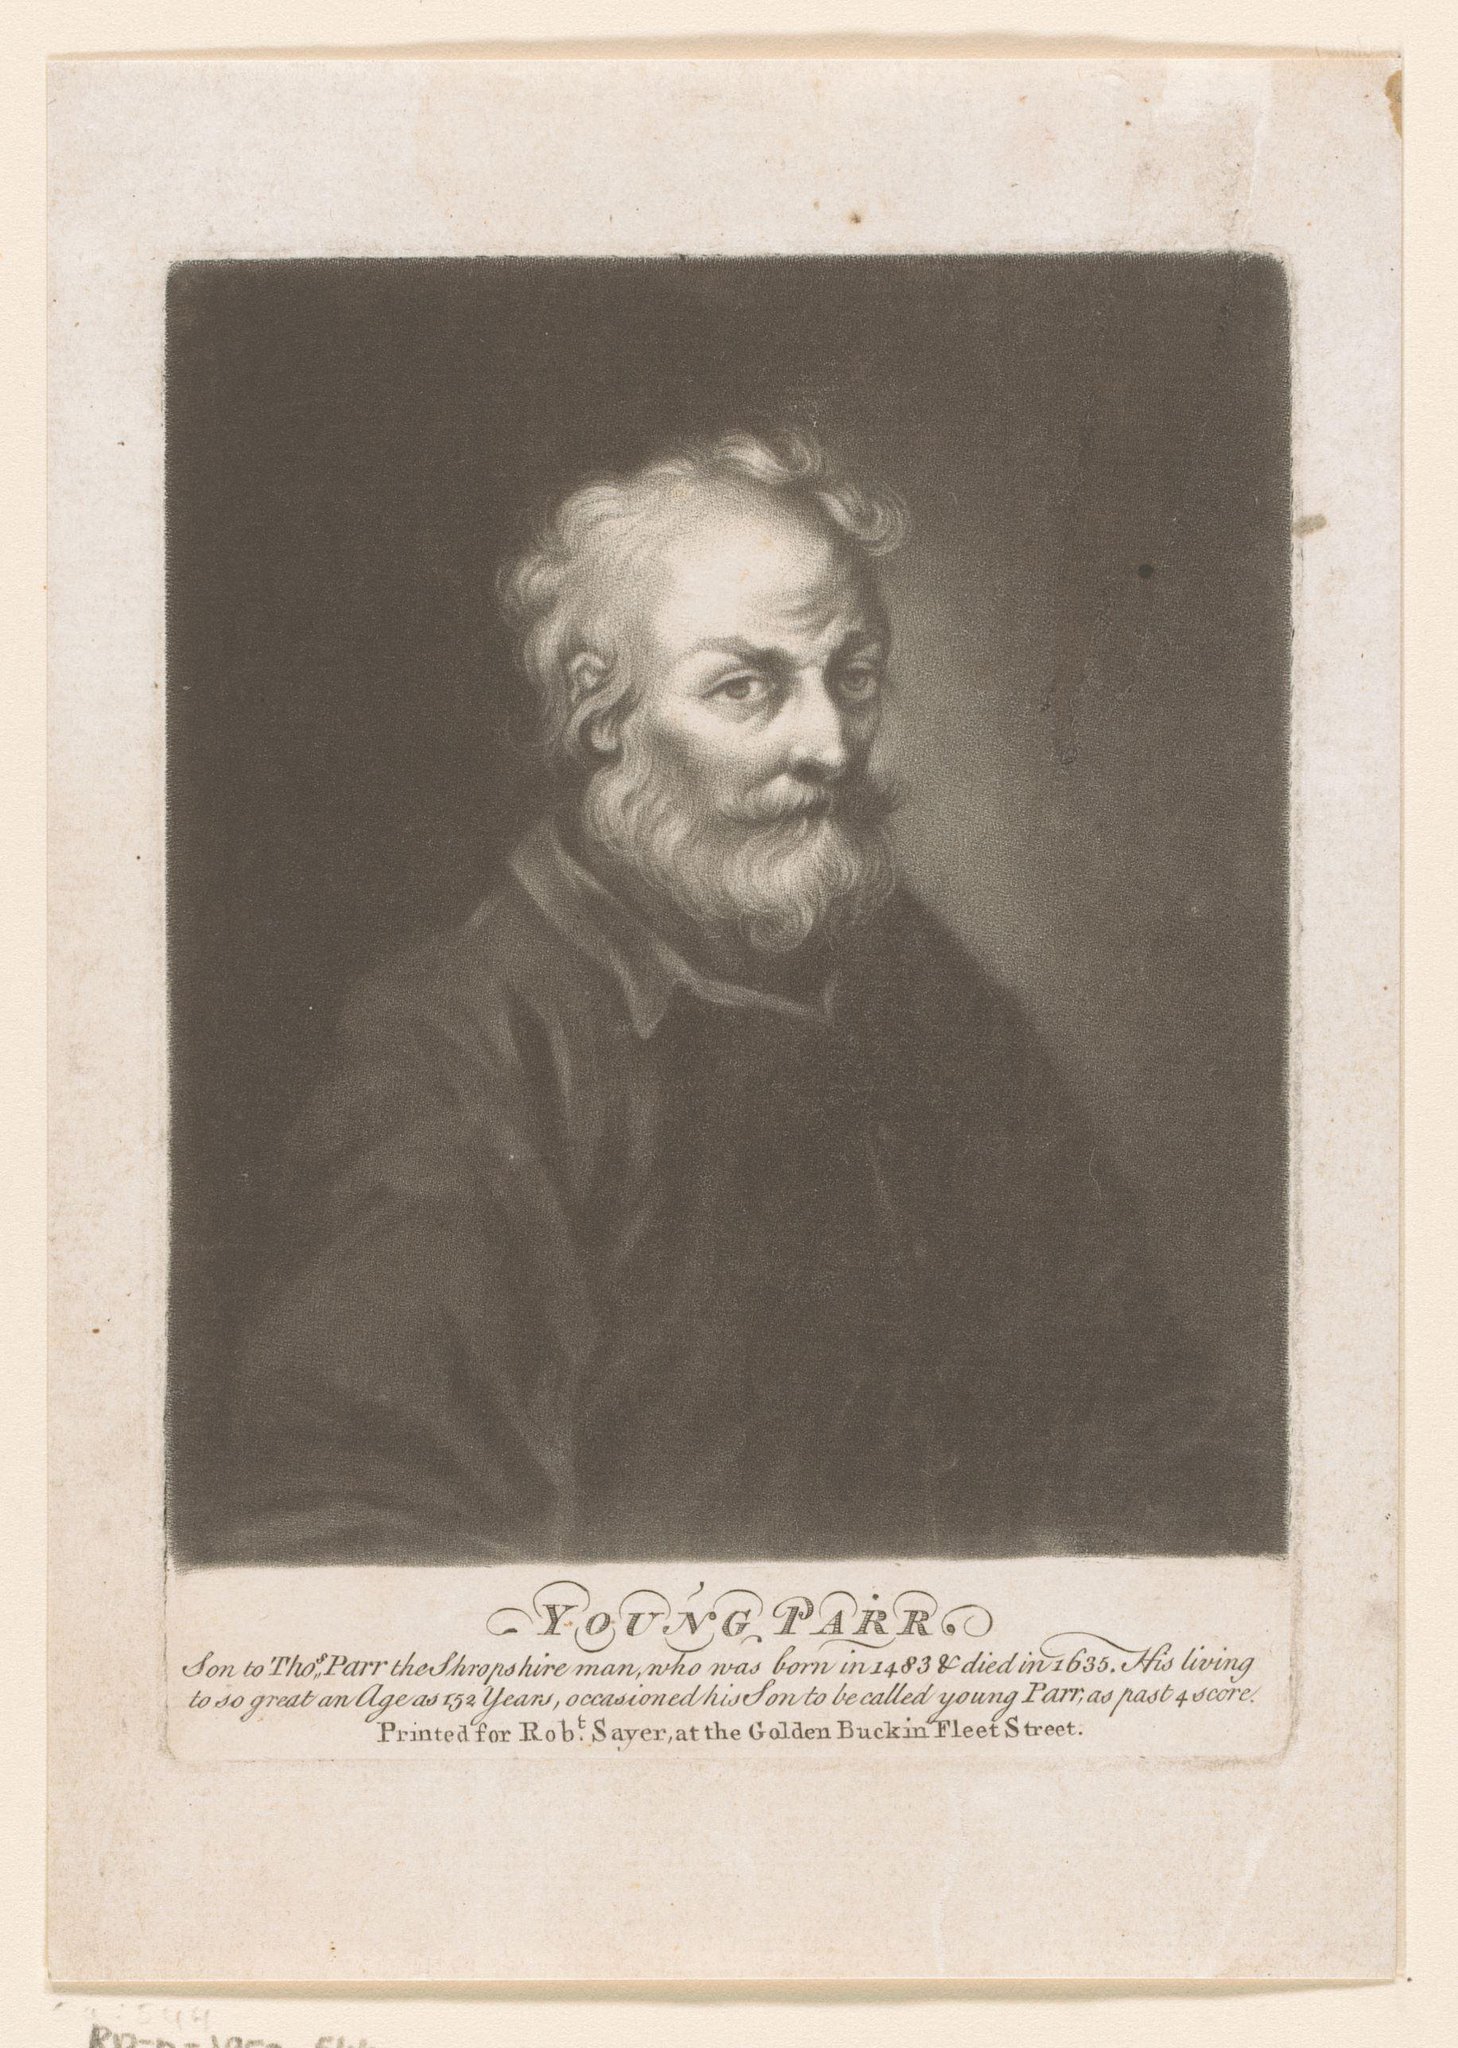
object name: print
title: Young Parr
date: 1745-1795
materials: paper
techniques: etching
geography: london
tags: historical persons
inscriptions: collector's mark: Lugt 2228